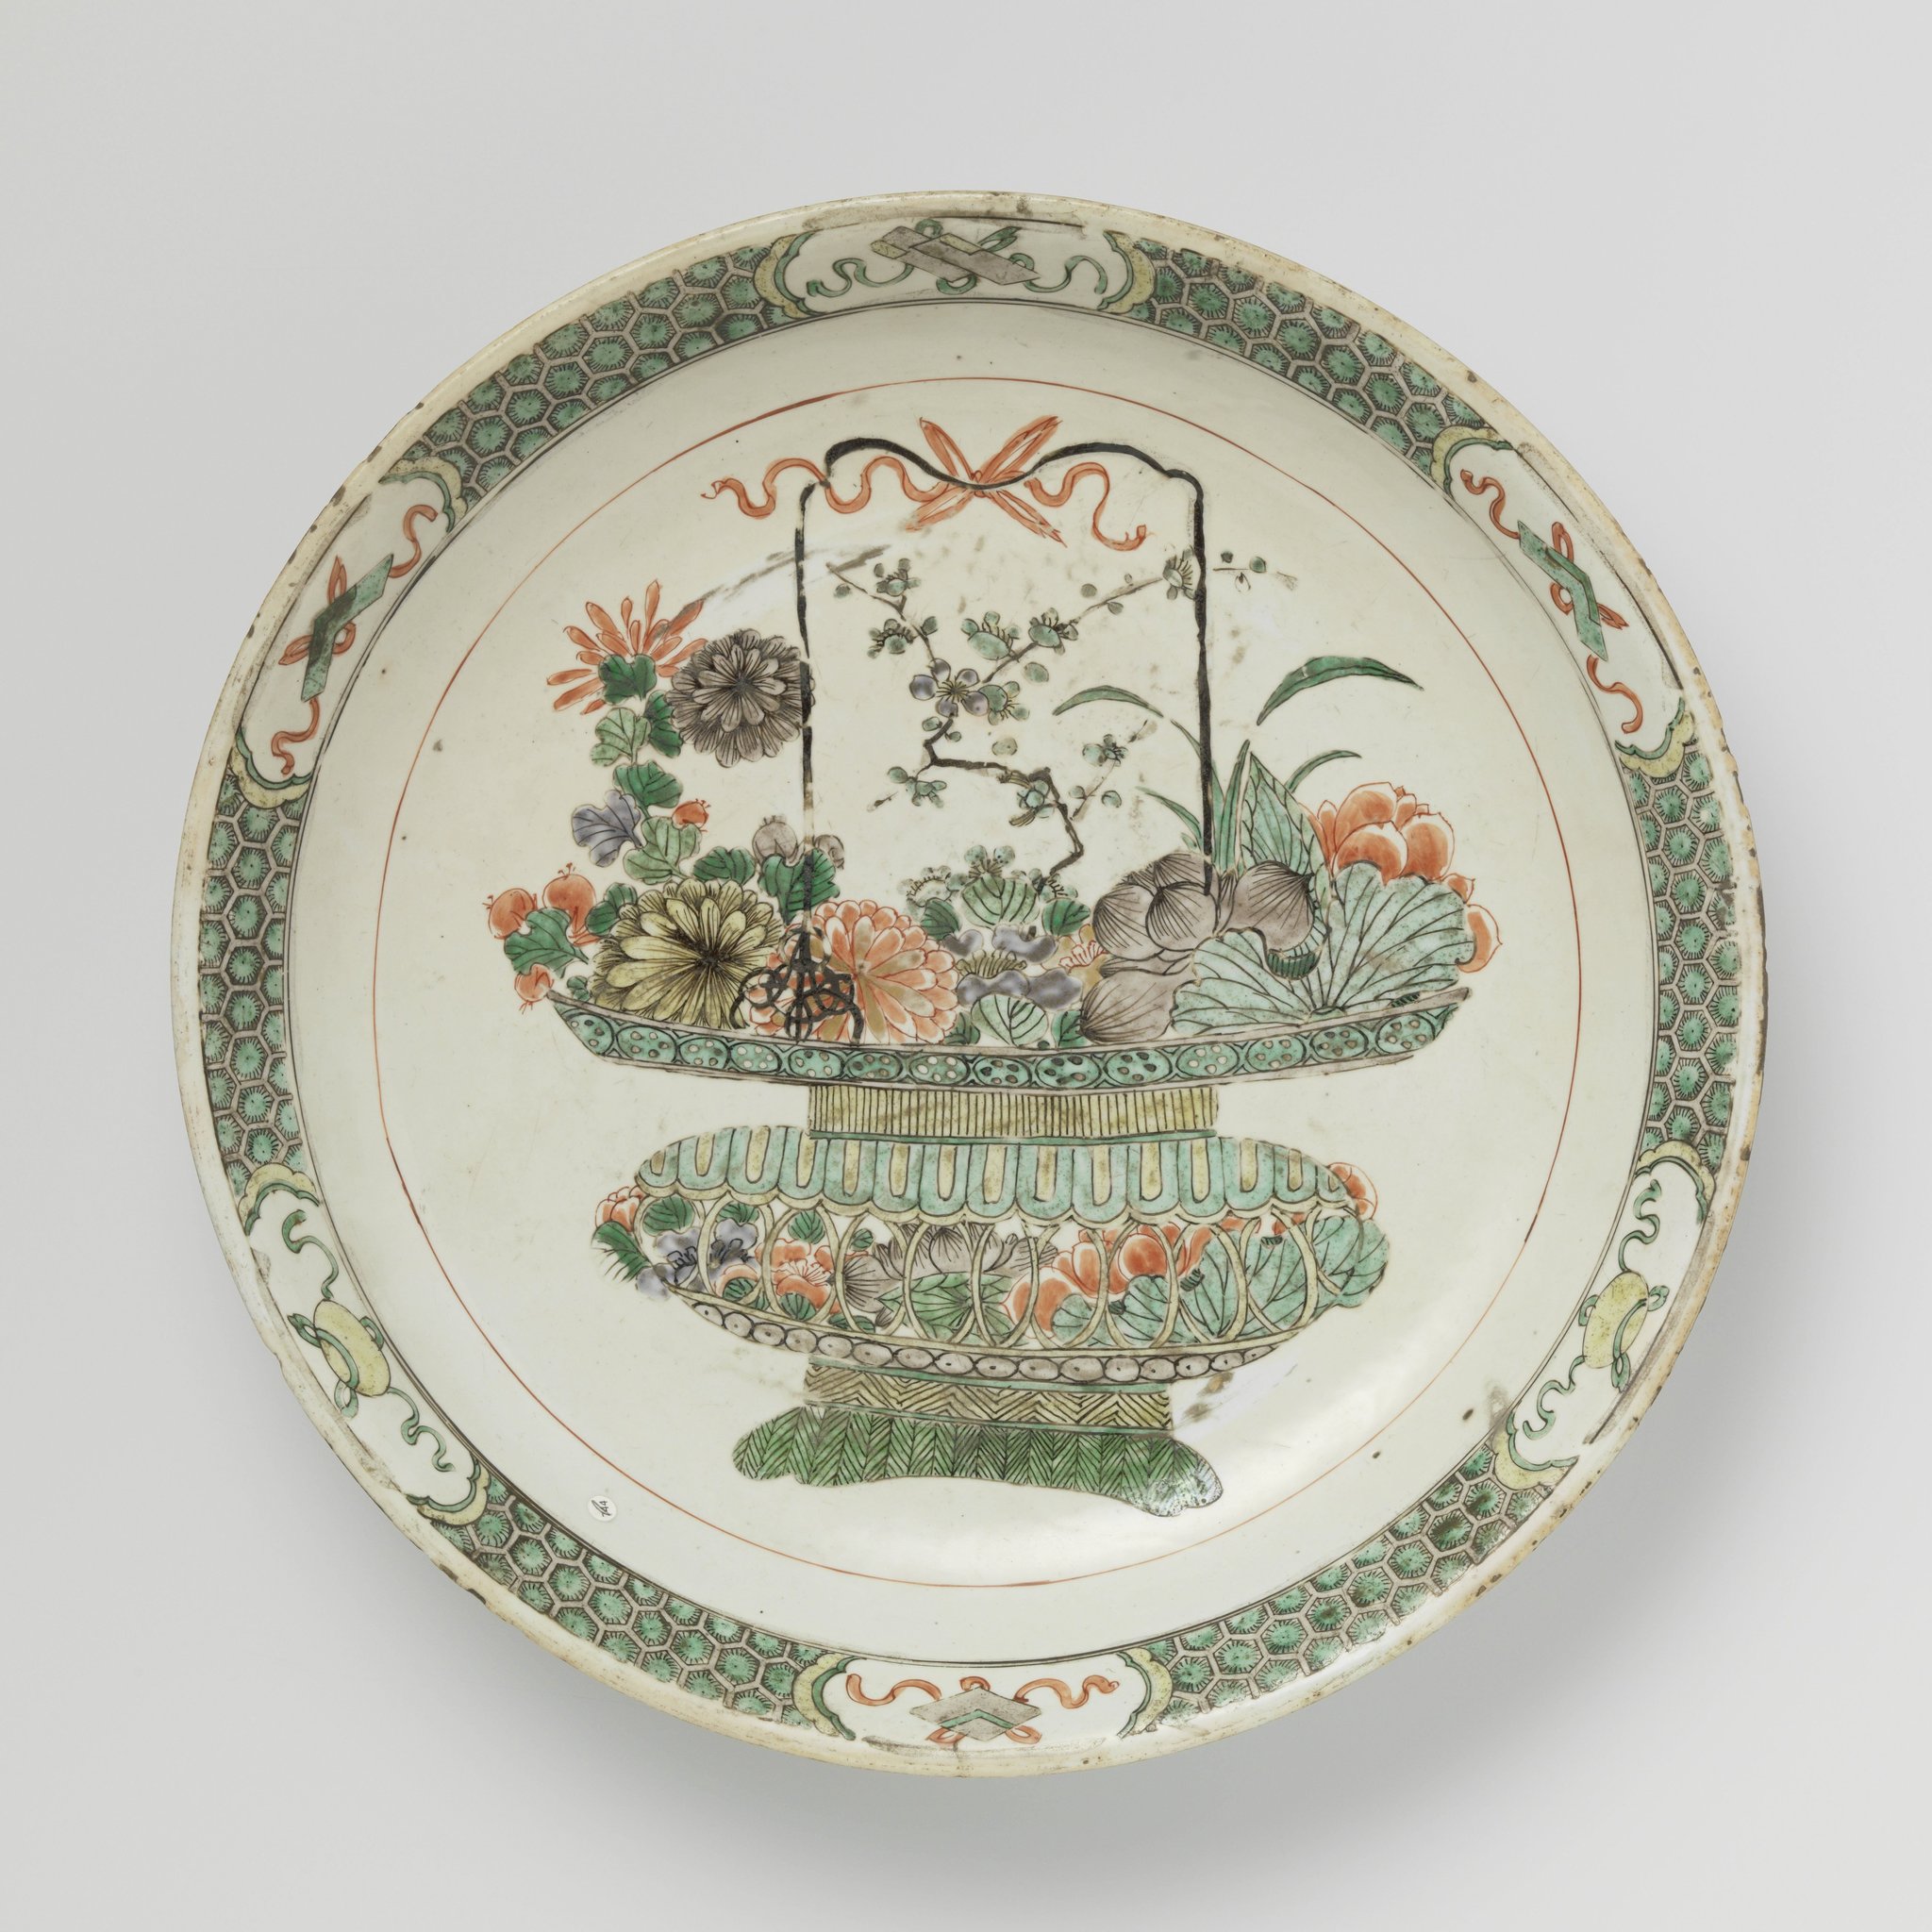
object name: platter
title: Saucer-dish with flowerbasket and precious objects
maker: Anonymous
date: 1700-1724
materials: cobalt, glaze, gold, paint, porcelain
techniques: firing, gilding, turning, vitrification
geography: china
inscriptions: mark